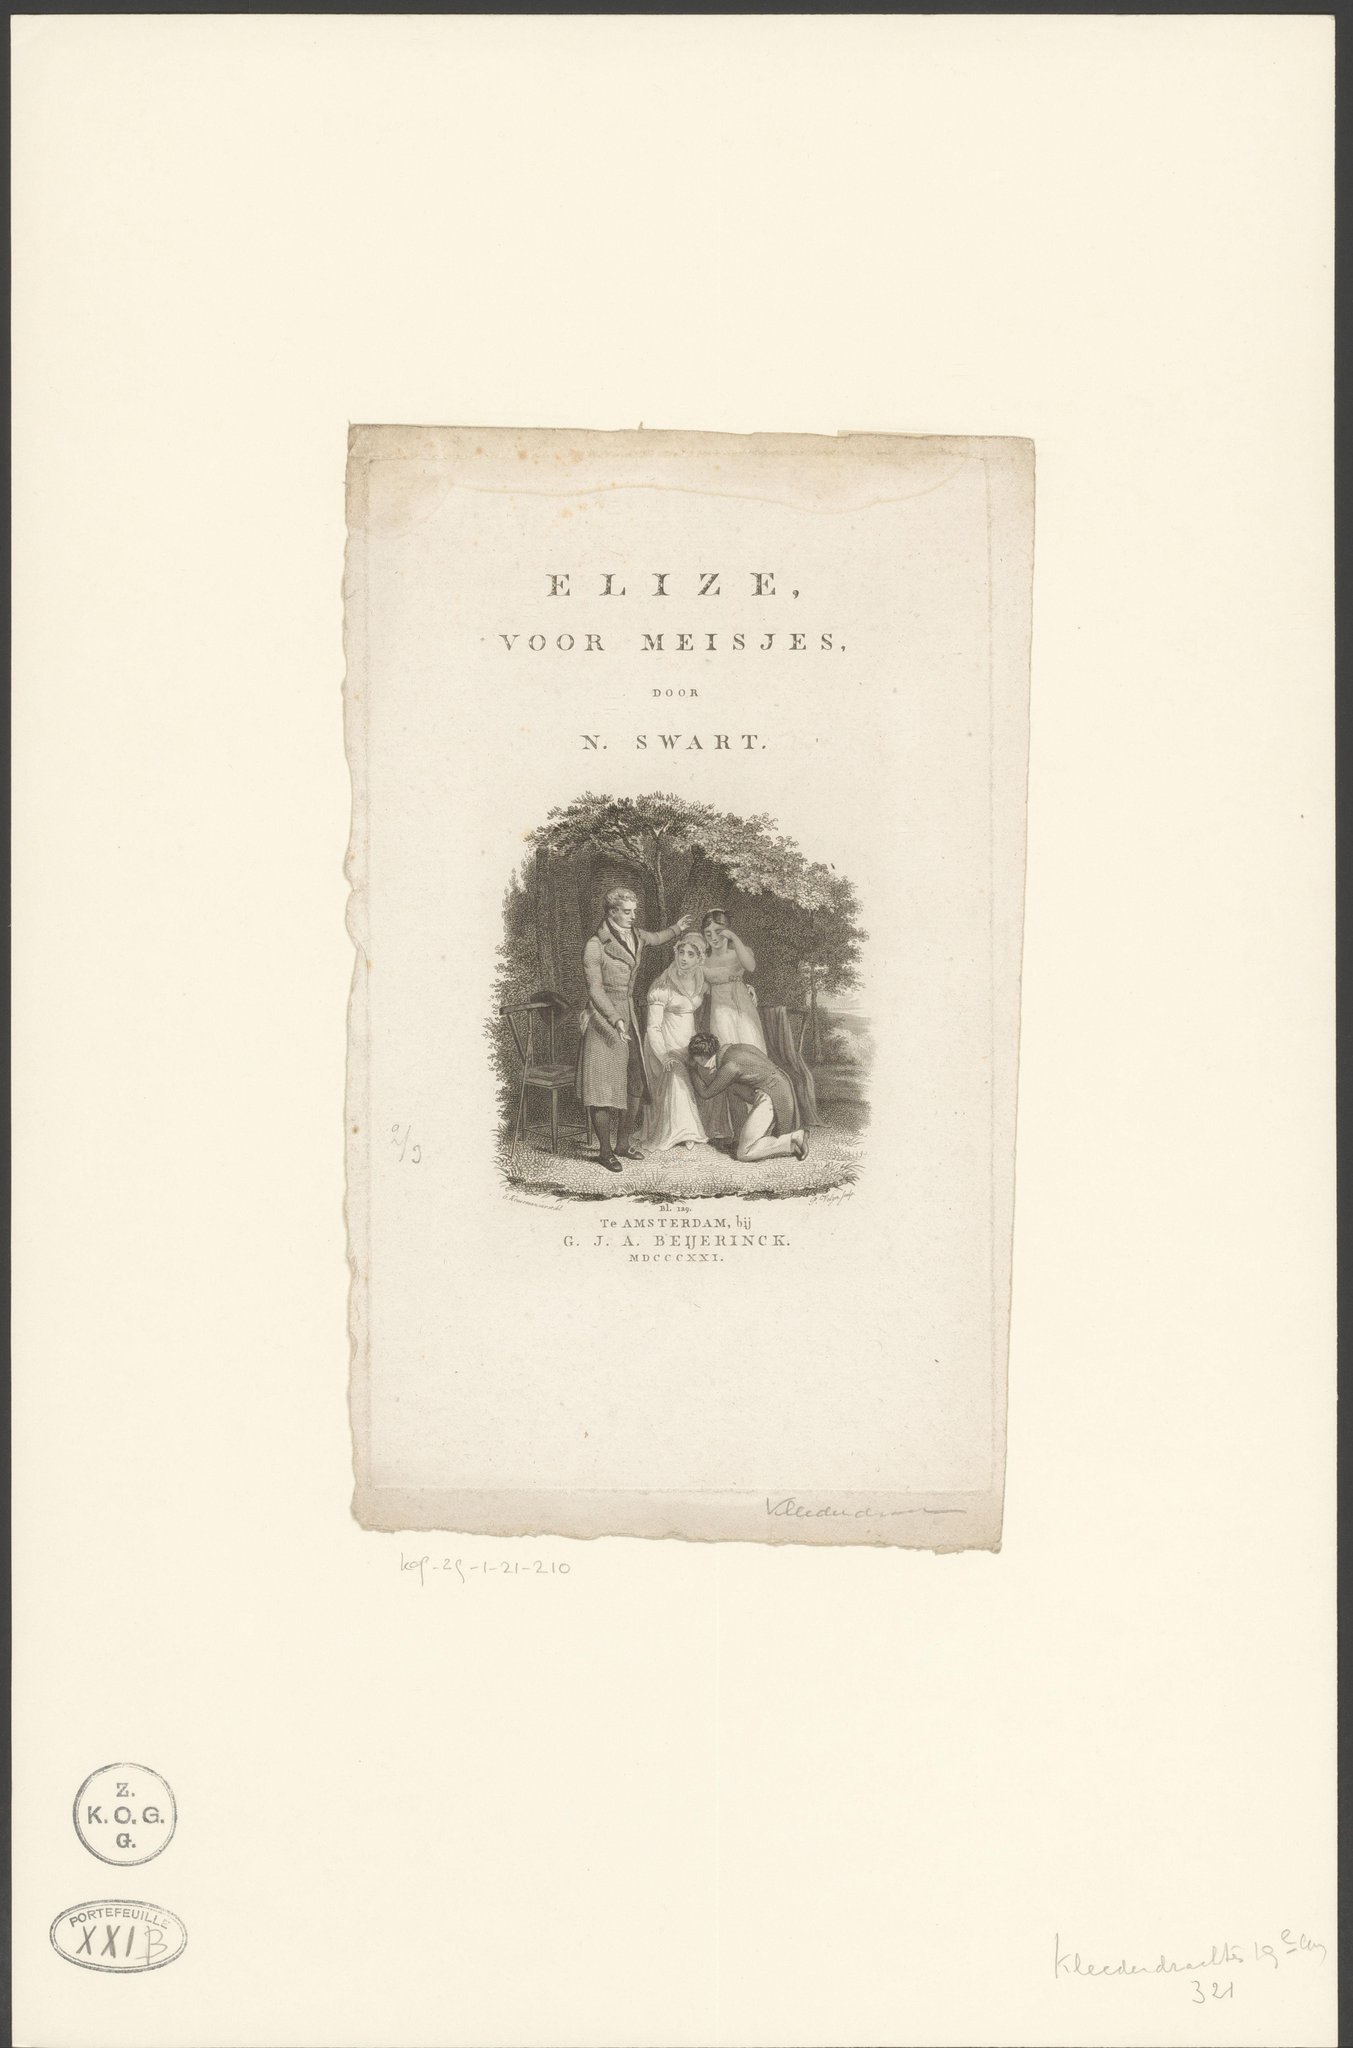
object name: print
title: Jongeman huilt geknield bij twee meisjes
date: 1821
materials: paper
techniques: engraving, etching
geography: amsterdam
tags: adolescent, young woman, maiden, father with daughter(s) (father-love), weeping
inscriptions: stamp, collector's mark: Lugt 1641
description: Onderwerpsrubrieken binnen de Atlas Zeden en Gewoonten: Zeden en Gewoonten in Engeren Zin, De Kleeding, Kleederdrachten (tijdvakken), Het begin der 19de eeuw. Mannen en vrouwen.